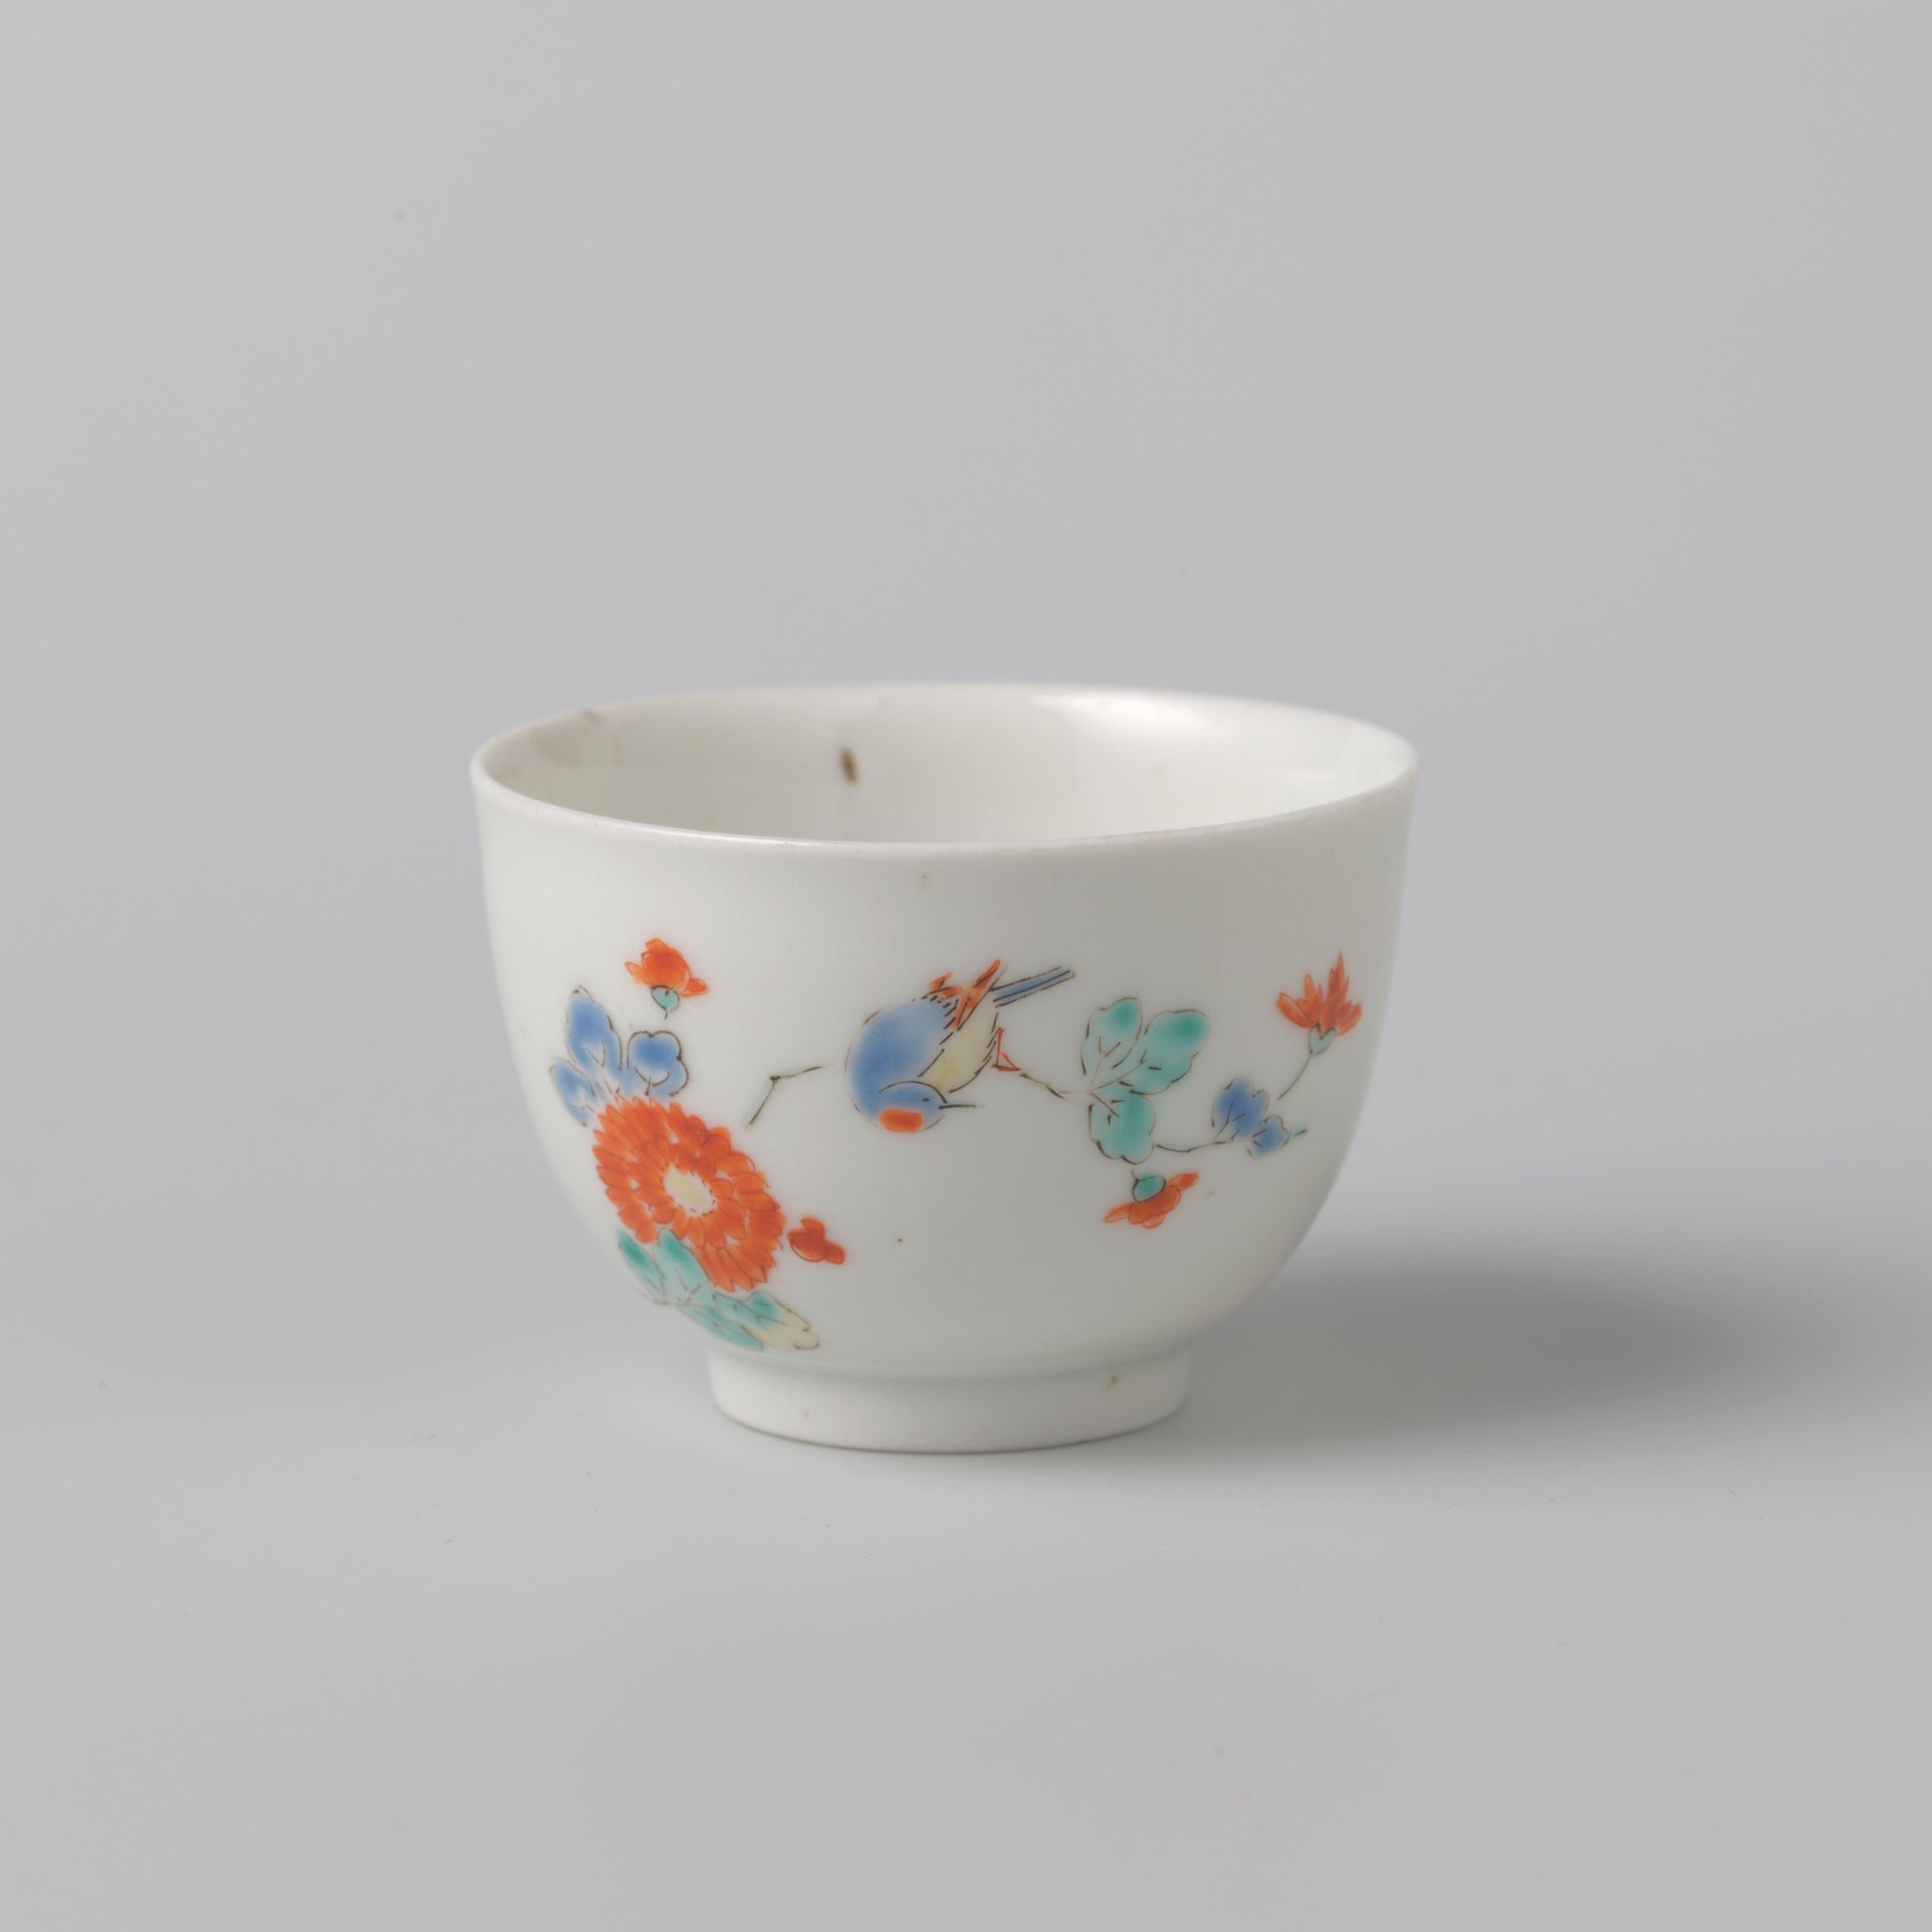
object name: cup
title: Cup with chrysanthemum and birds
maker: Anonymous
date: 1670-1700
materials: glaze, paint, porcelain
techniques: firing, turning, vitrification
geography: arita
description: Two cups and a saucer, c. 1690 - 1720. Jonkvrouwe A.C.A.J. Clifford bequest, 1960.